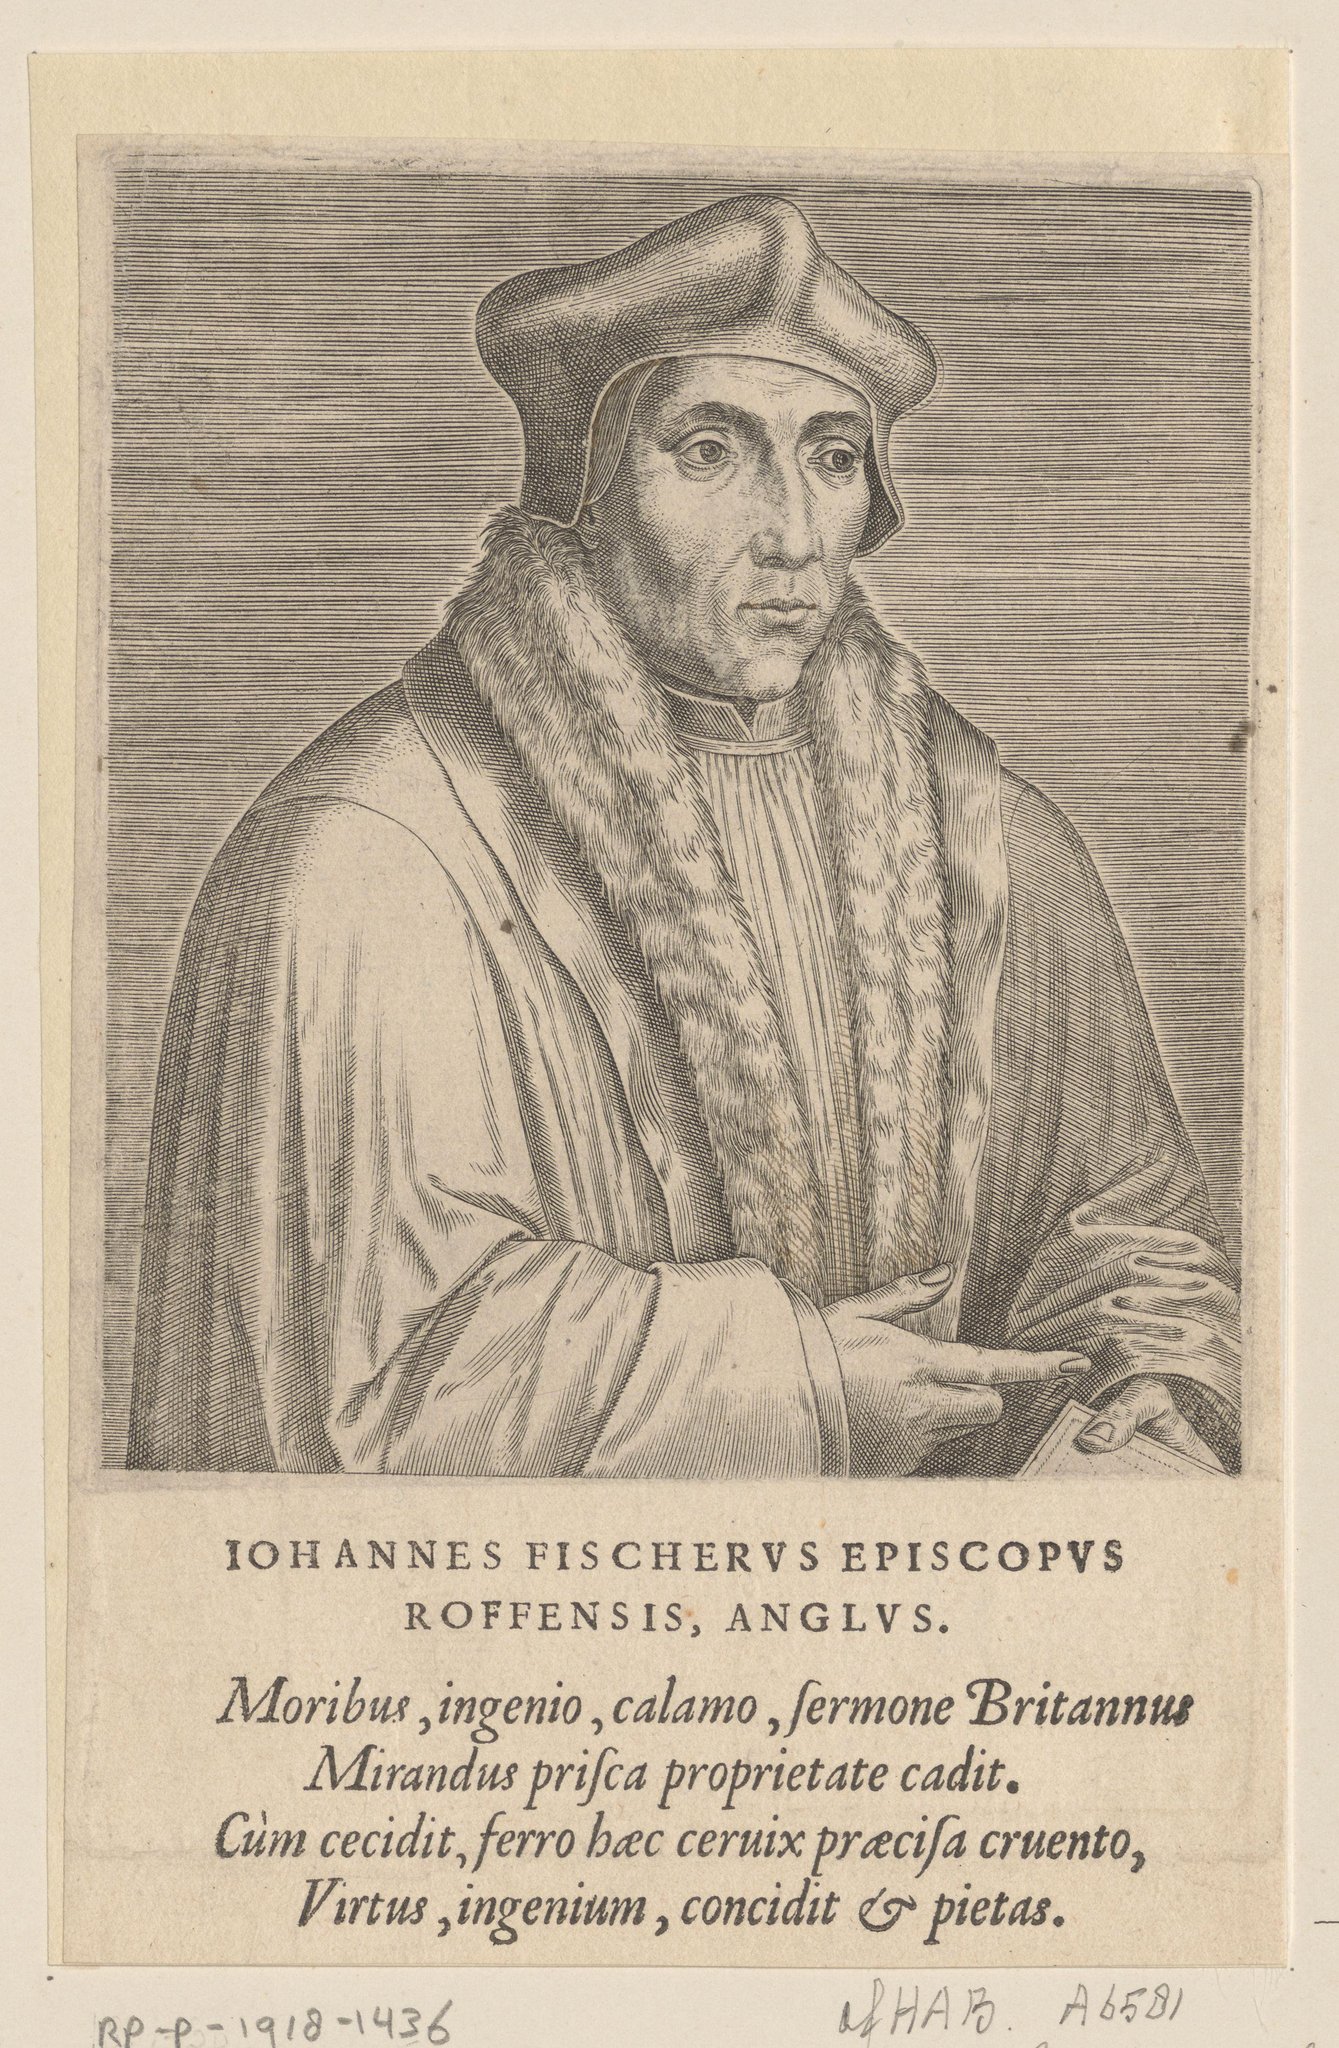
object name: print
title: Portretten van beroemde Europese geleerden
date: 1572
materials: paper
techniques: engraving, letterpress printing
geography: antwerp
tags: archbishop, bishop, etc. (roman catholic), historical persons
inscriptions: collector's mark: Lugt 2233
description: Prent eerder gebruikt in de editie van 1567.